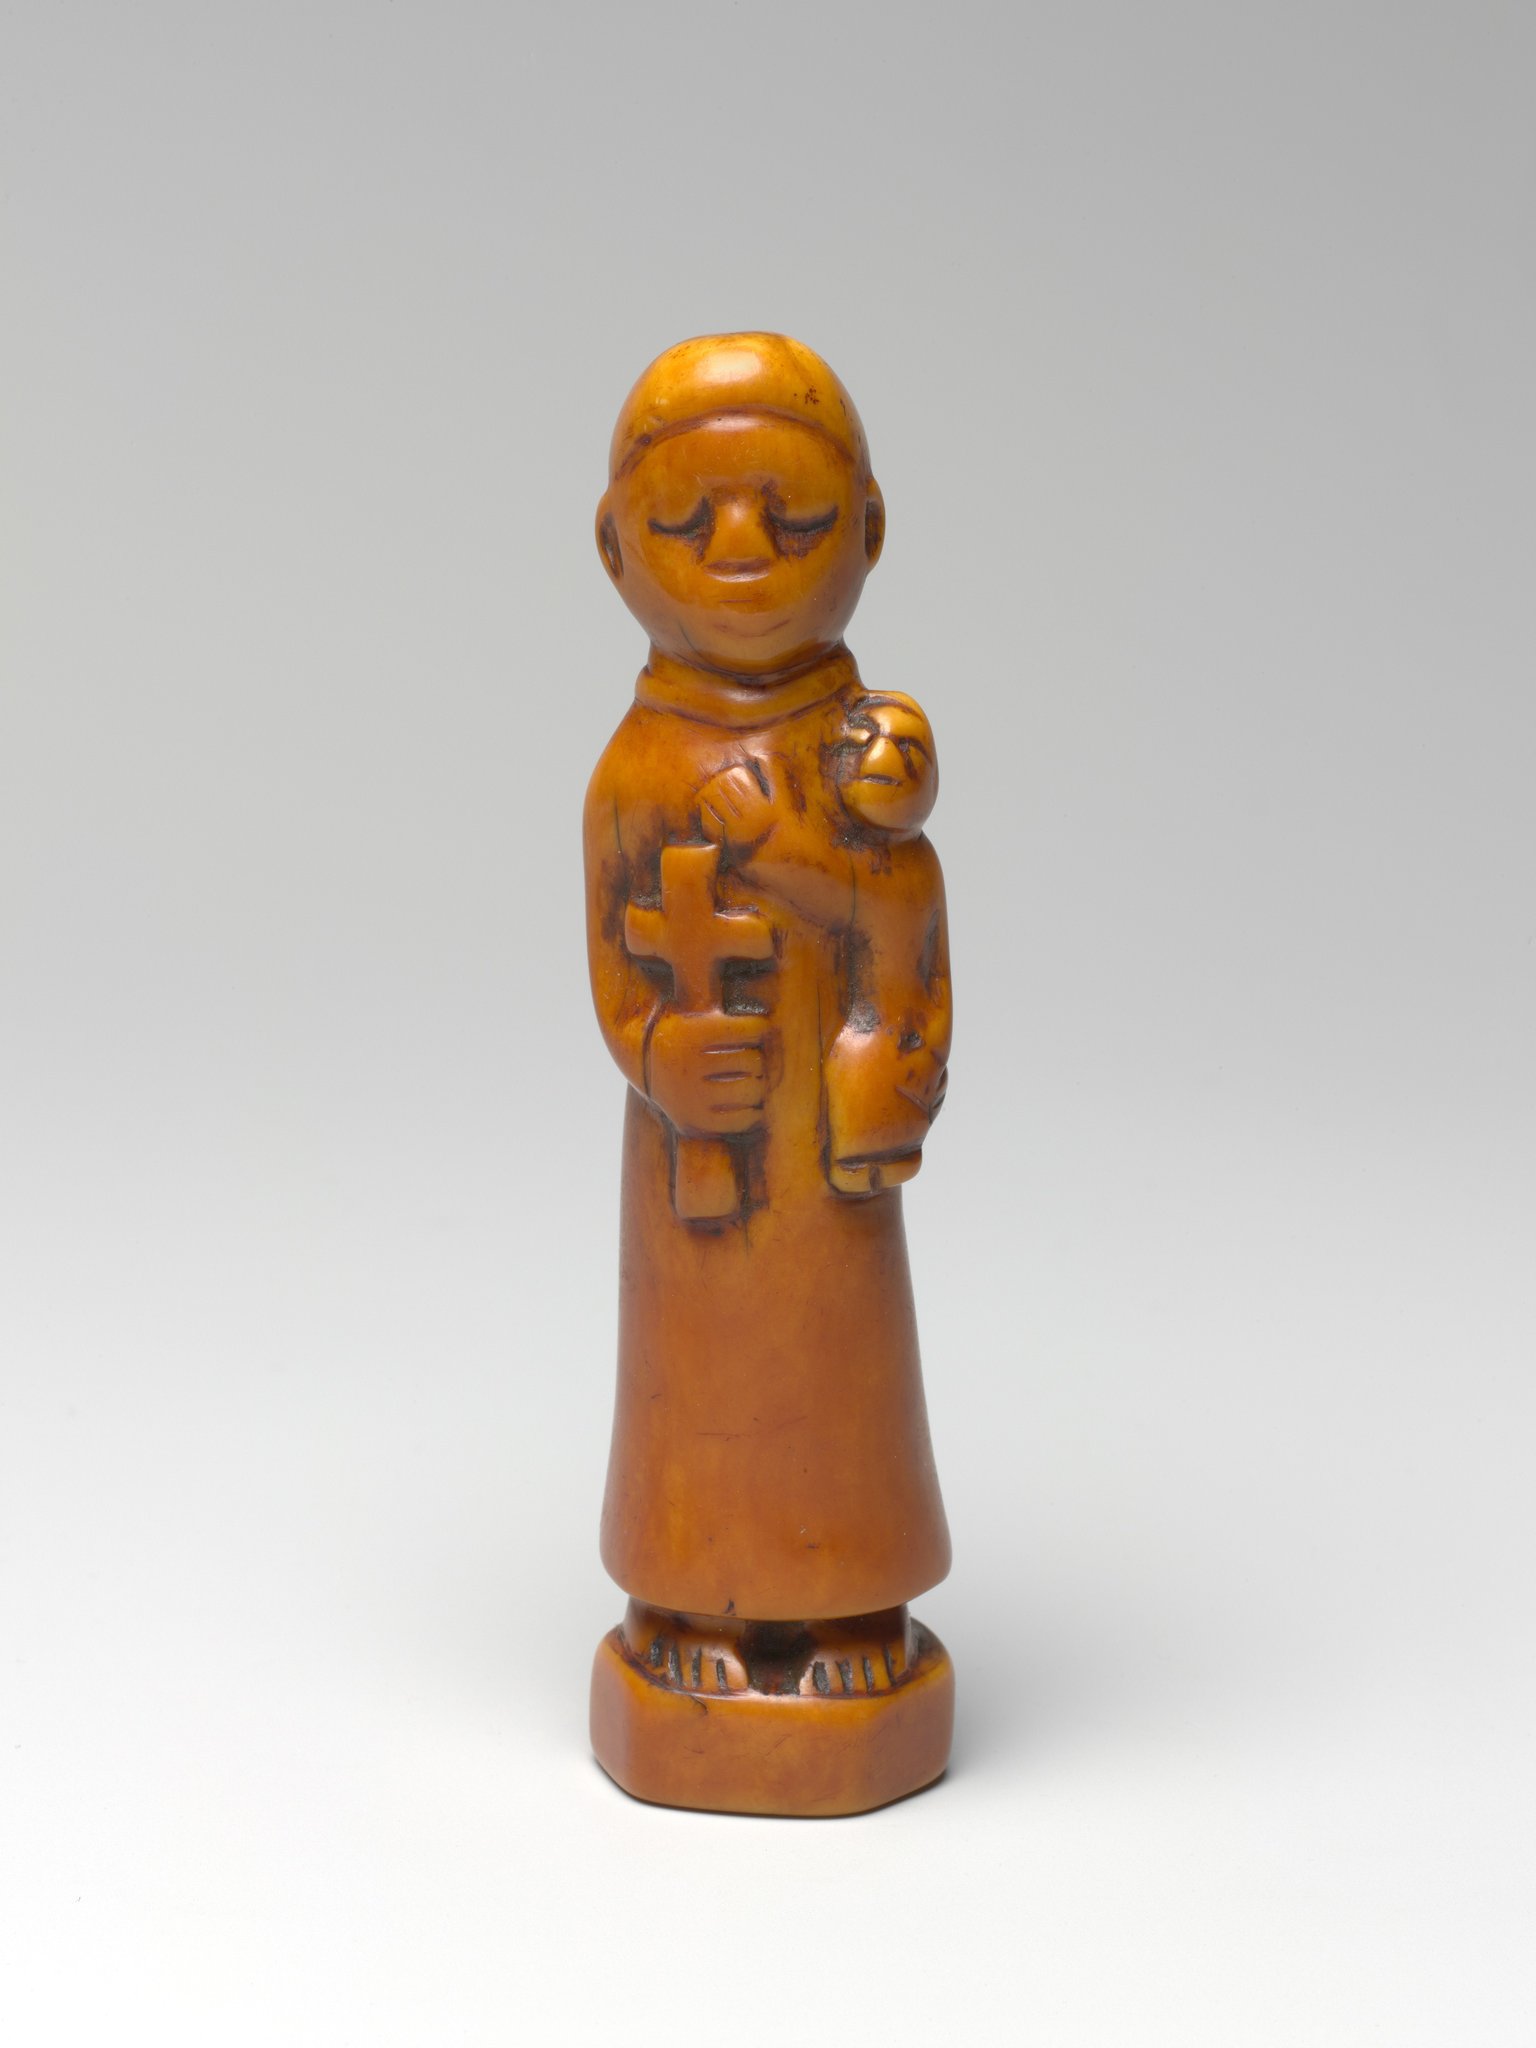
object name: figure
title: Figure: Saint Anthony (Toni Malau)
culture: kongo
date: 1701-1800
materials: ivory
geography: angola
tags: saint anthony,cross,jesus